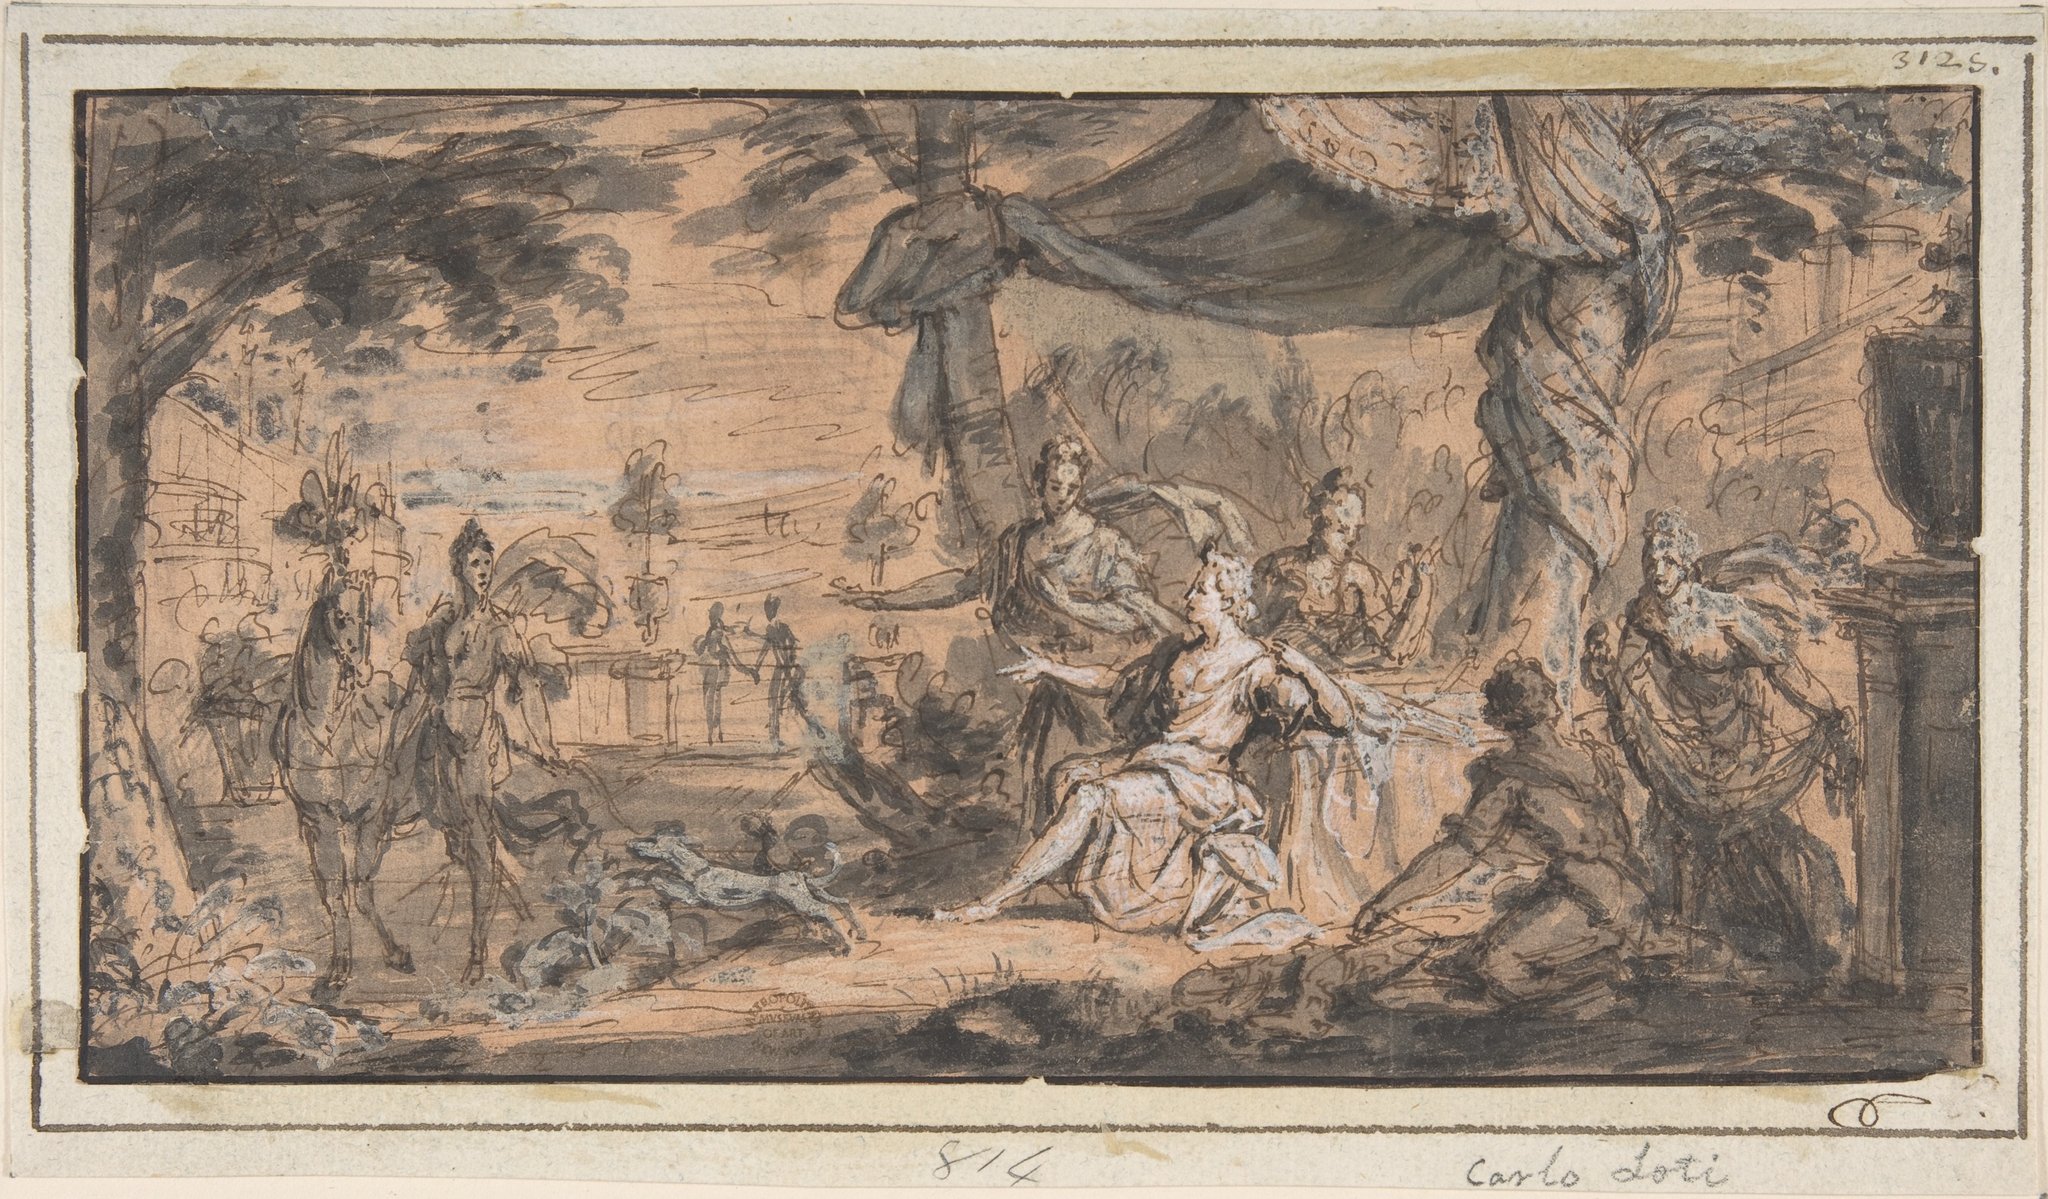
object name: drawing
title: Alexander and Bucephalus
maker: anonymous, french, 17th century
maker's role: artist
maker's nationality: french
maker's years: 1600-1700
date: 1601-1700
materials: ink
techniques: brush, pen, wash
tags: alexander the great,men,women,horses